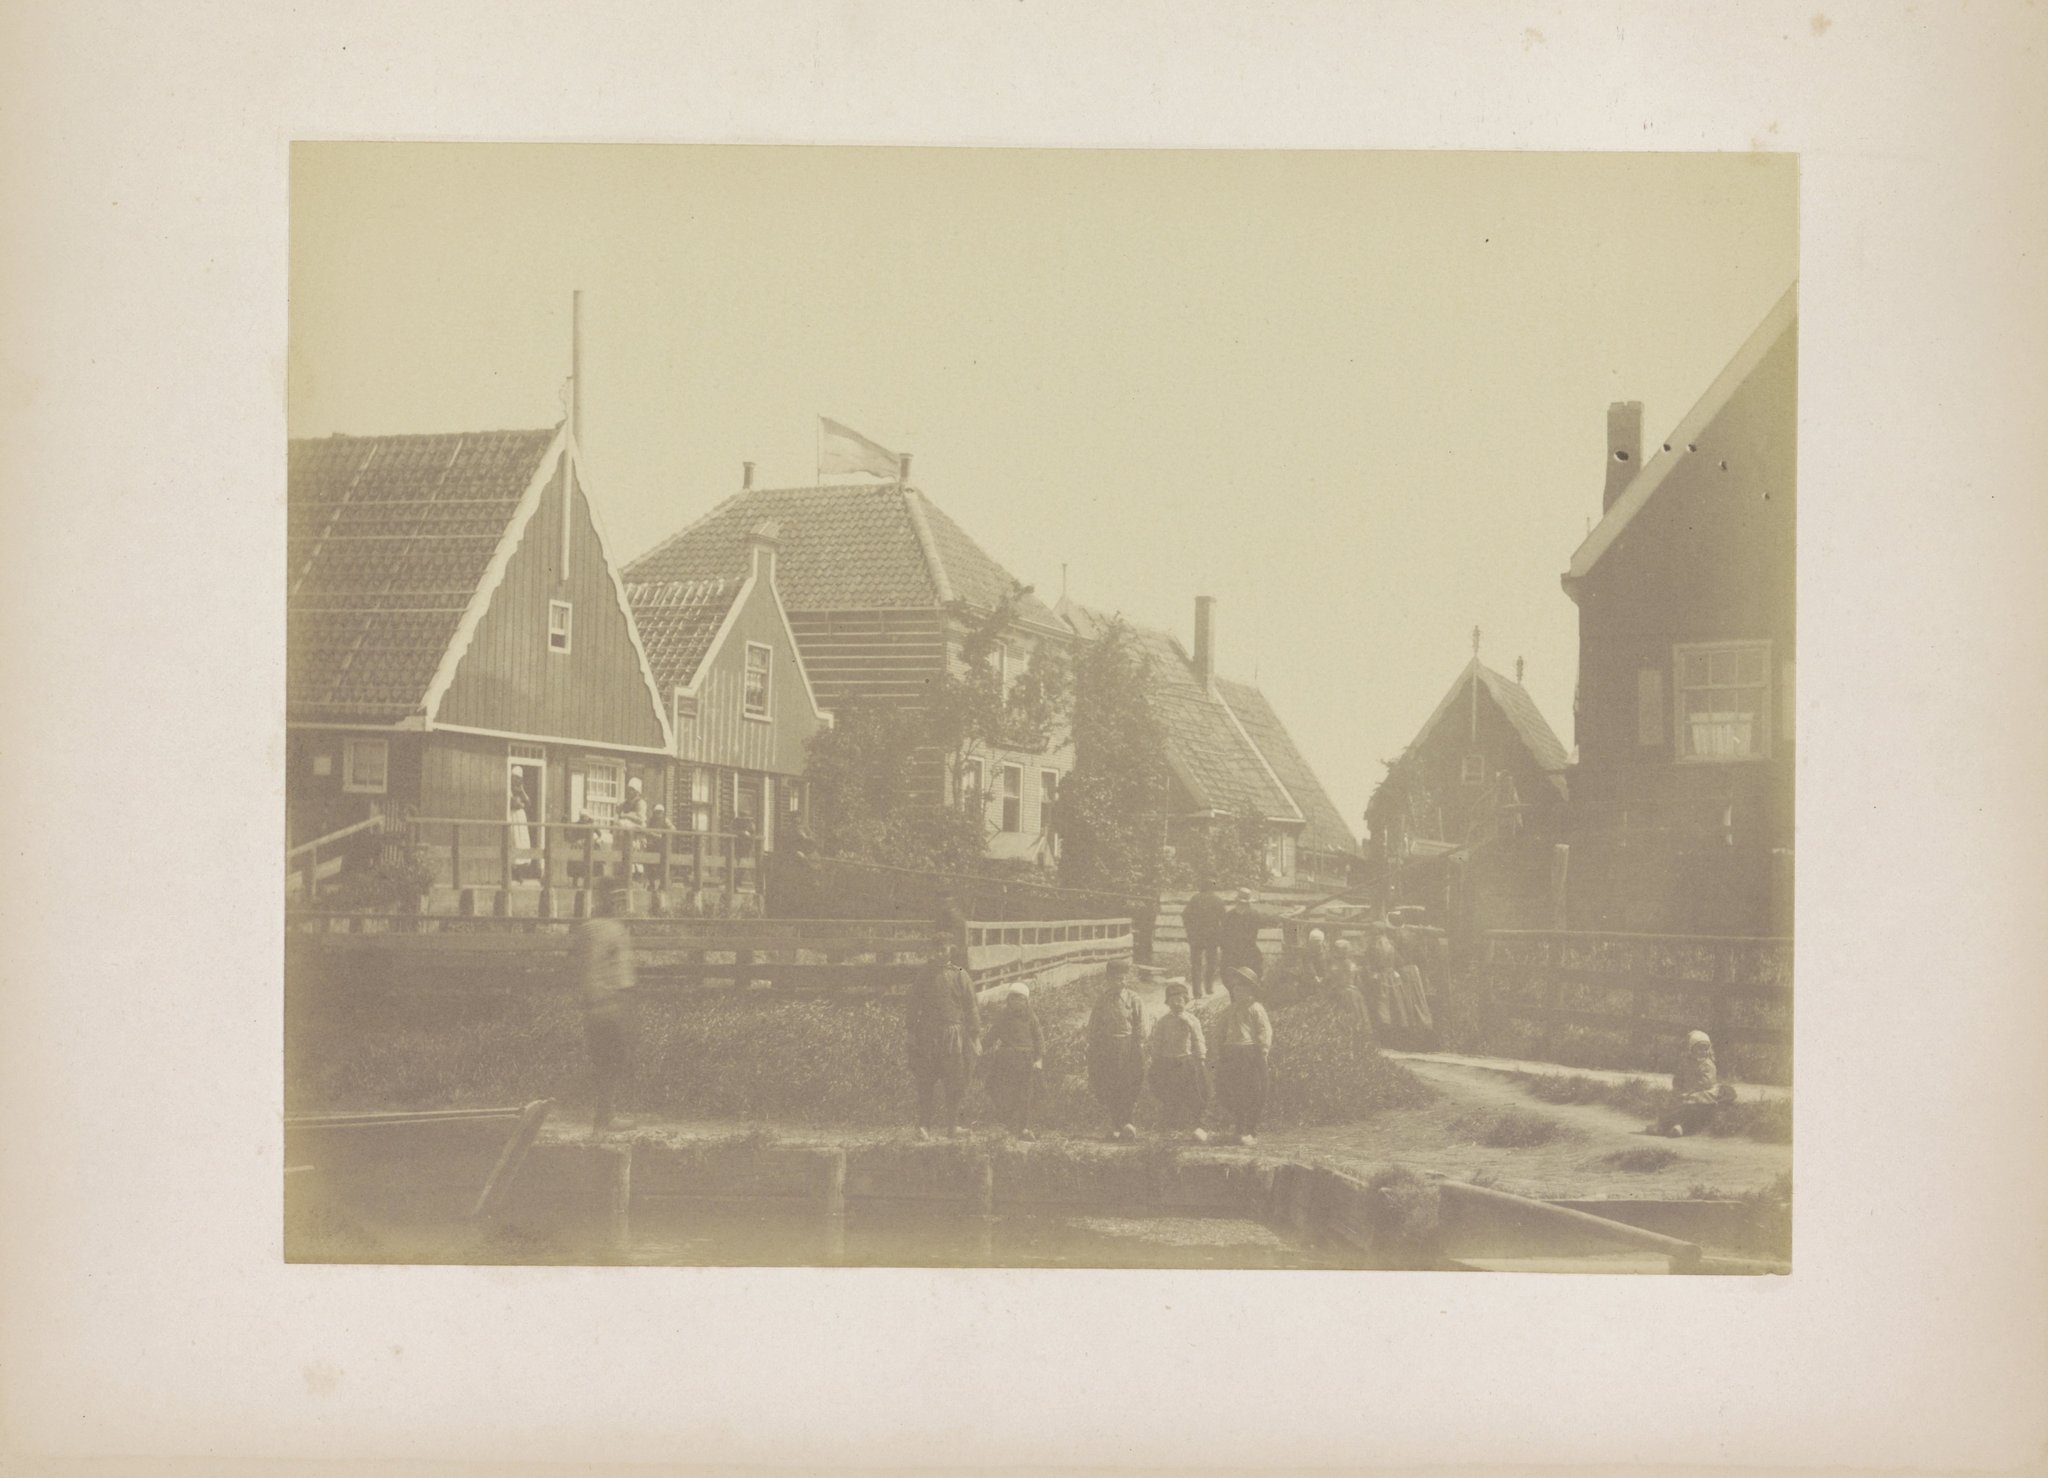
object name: photograph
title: ((...)) Marken / (Hollande)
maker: Anonymous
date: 1885-1900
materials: paper, photographic support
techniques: albumen print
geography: france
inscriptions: annotation: ‘(...) Marken / (Hollande)’